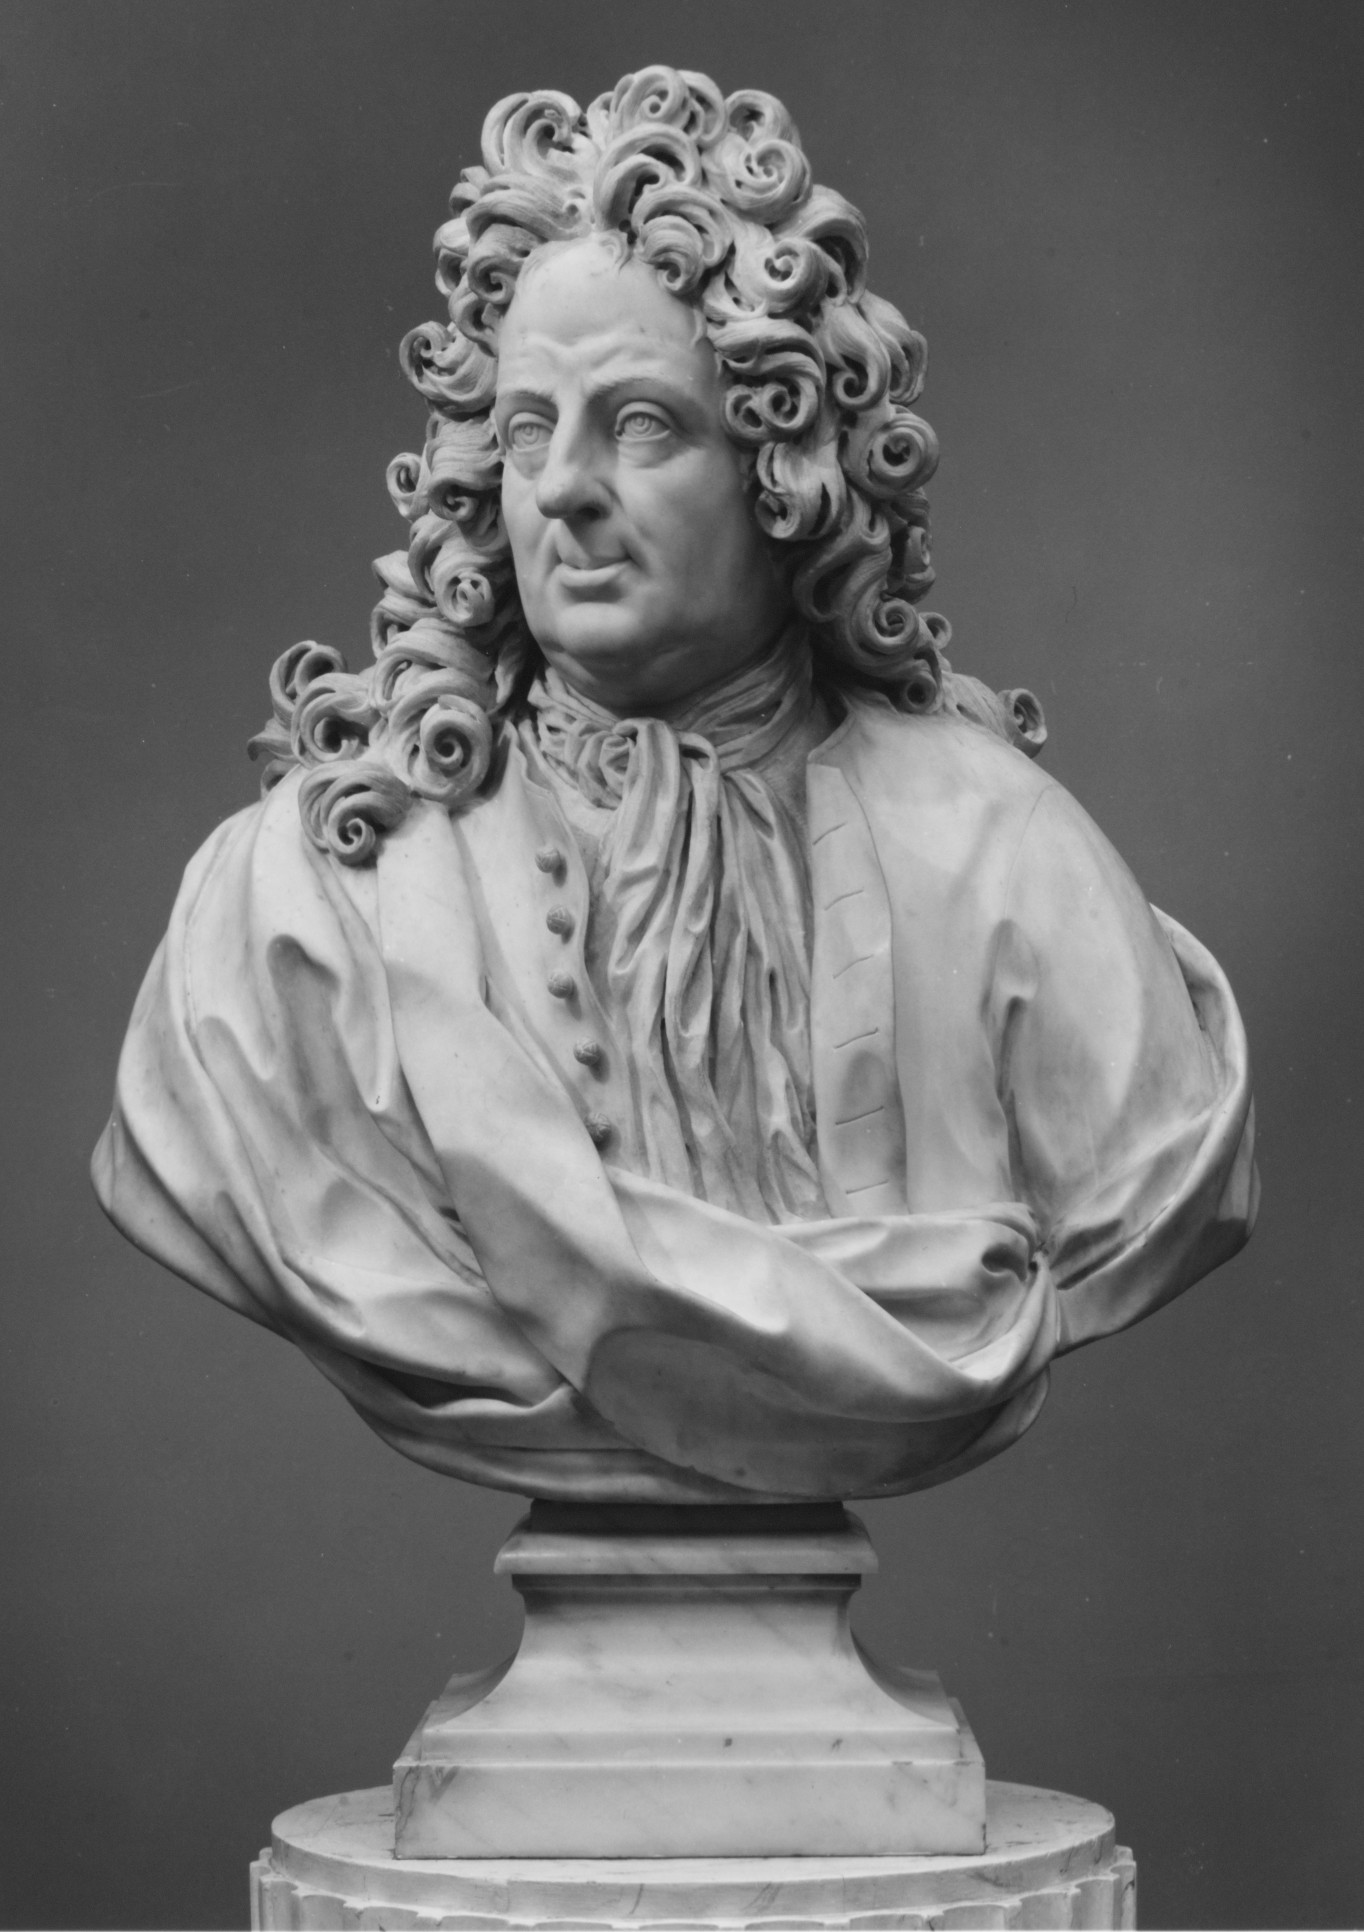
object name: bust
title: Giovanni Andrea Muti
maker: bernardino cametti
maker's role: artist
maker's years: 1670-1736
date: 1725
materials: marble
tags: men,portraits